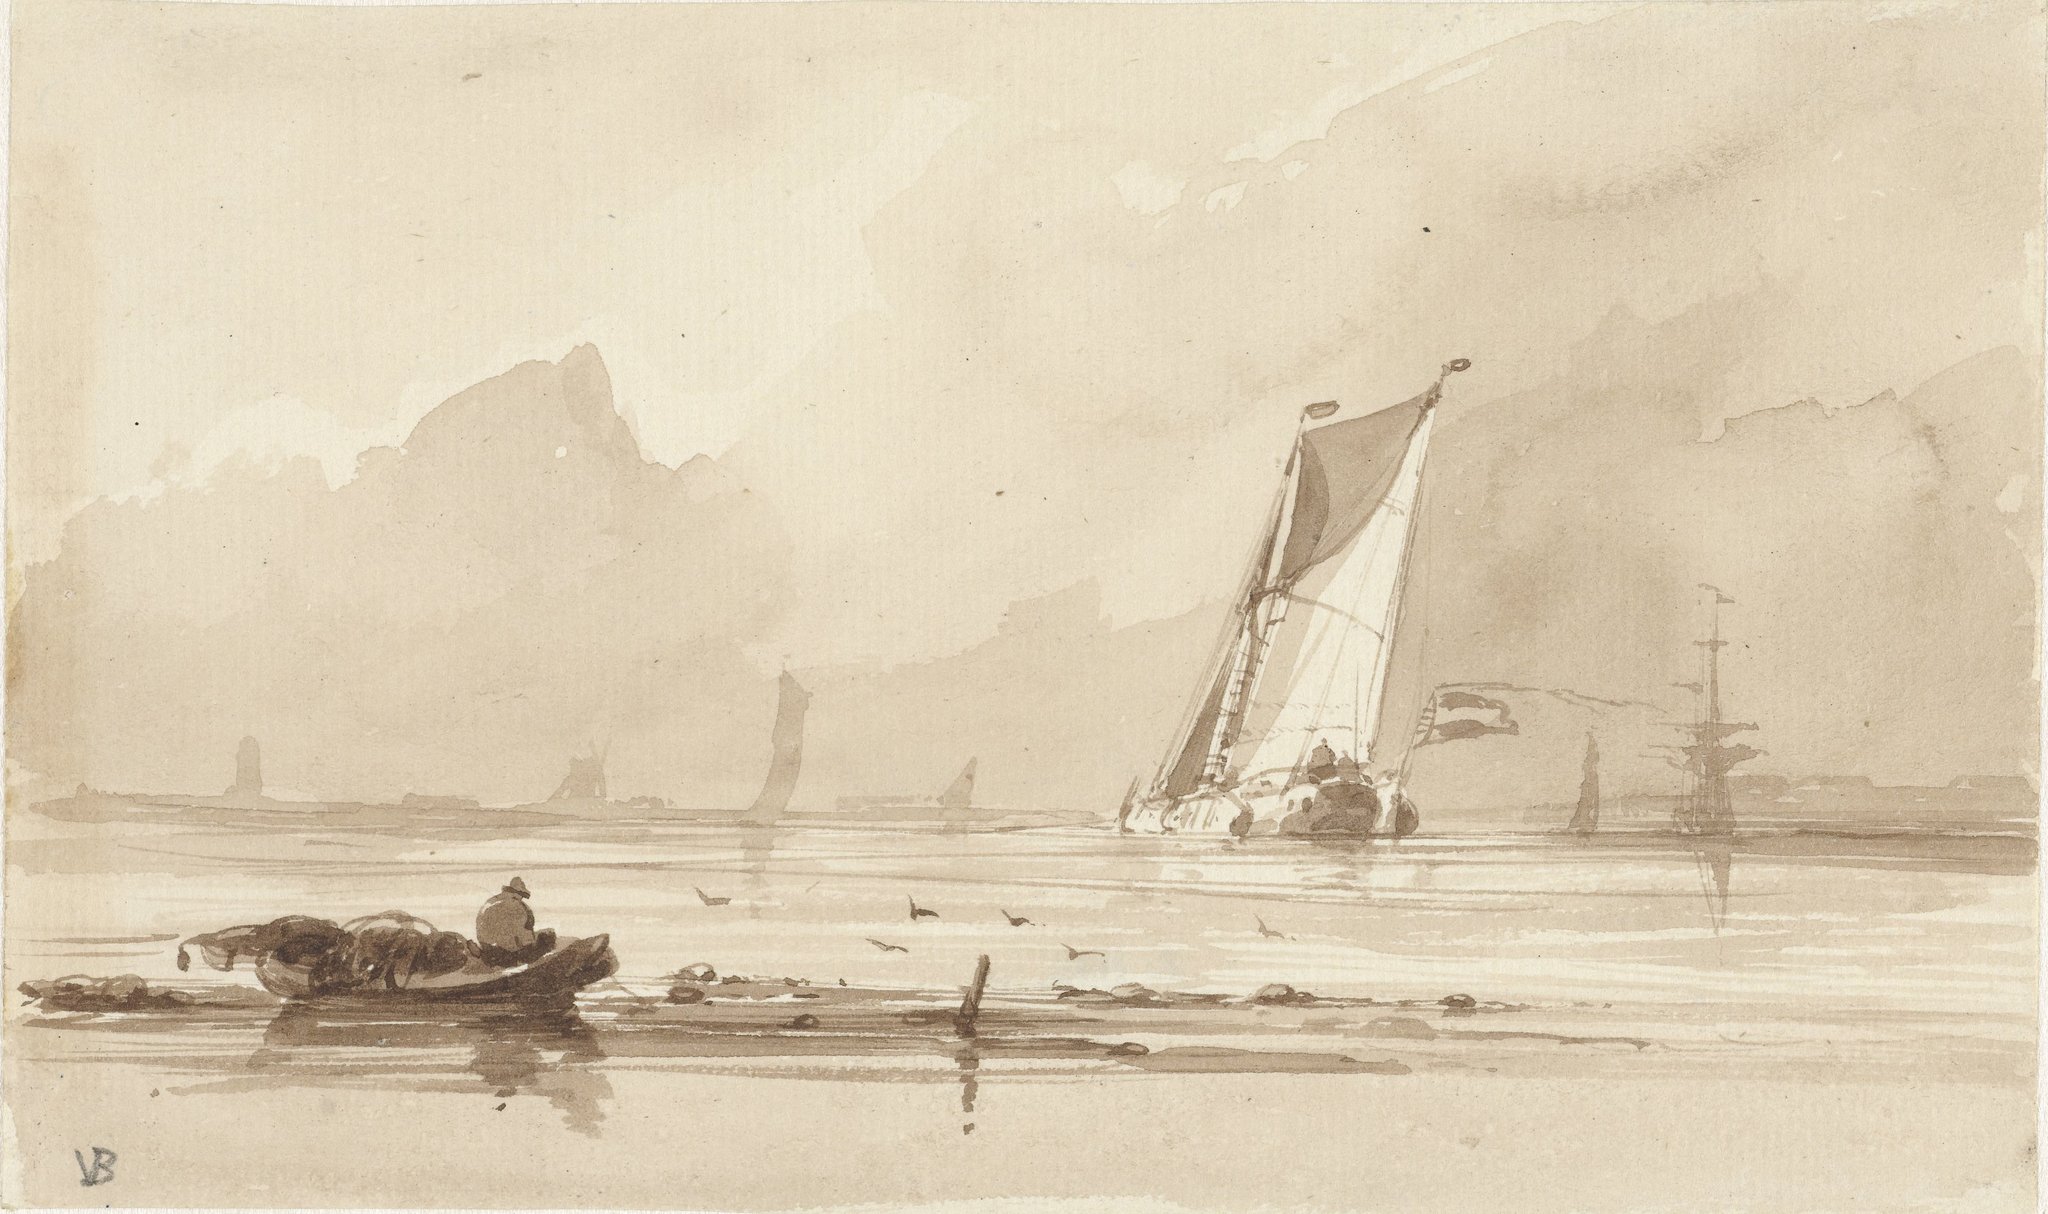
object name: drawing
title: Zeegezicht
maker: albertus van beest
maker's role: draughtsman, print maker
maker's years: 1820-1860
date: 1830-1860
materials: ink, paper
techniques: brush, pen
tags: sailing-ship, sailing-boat